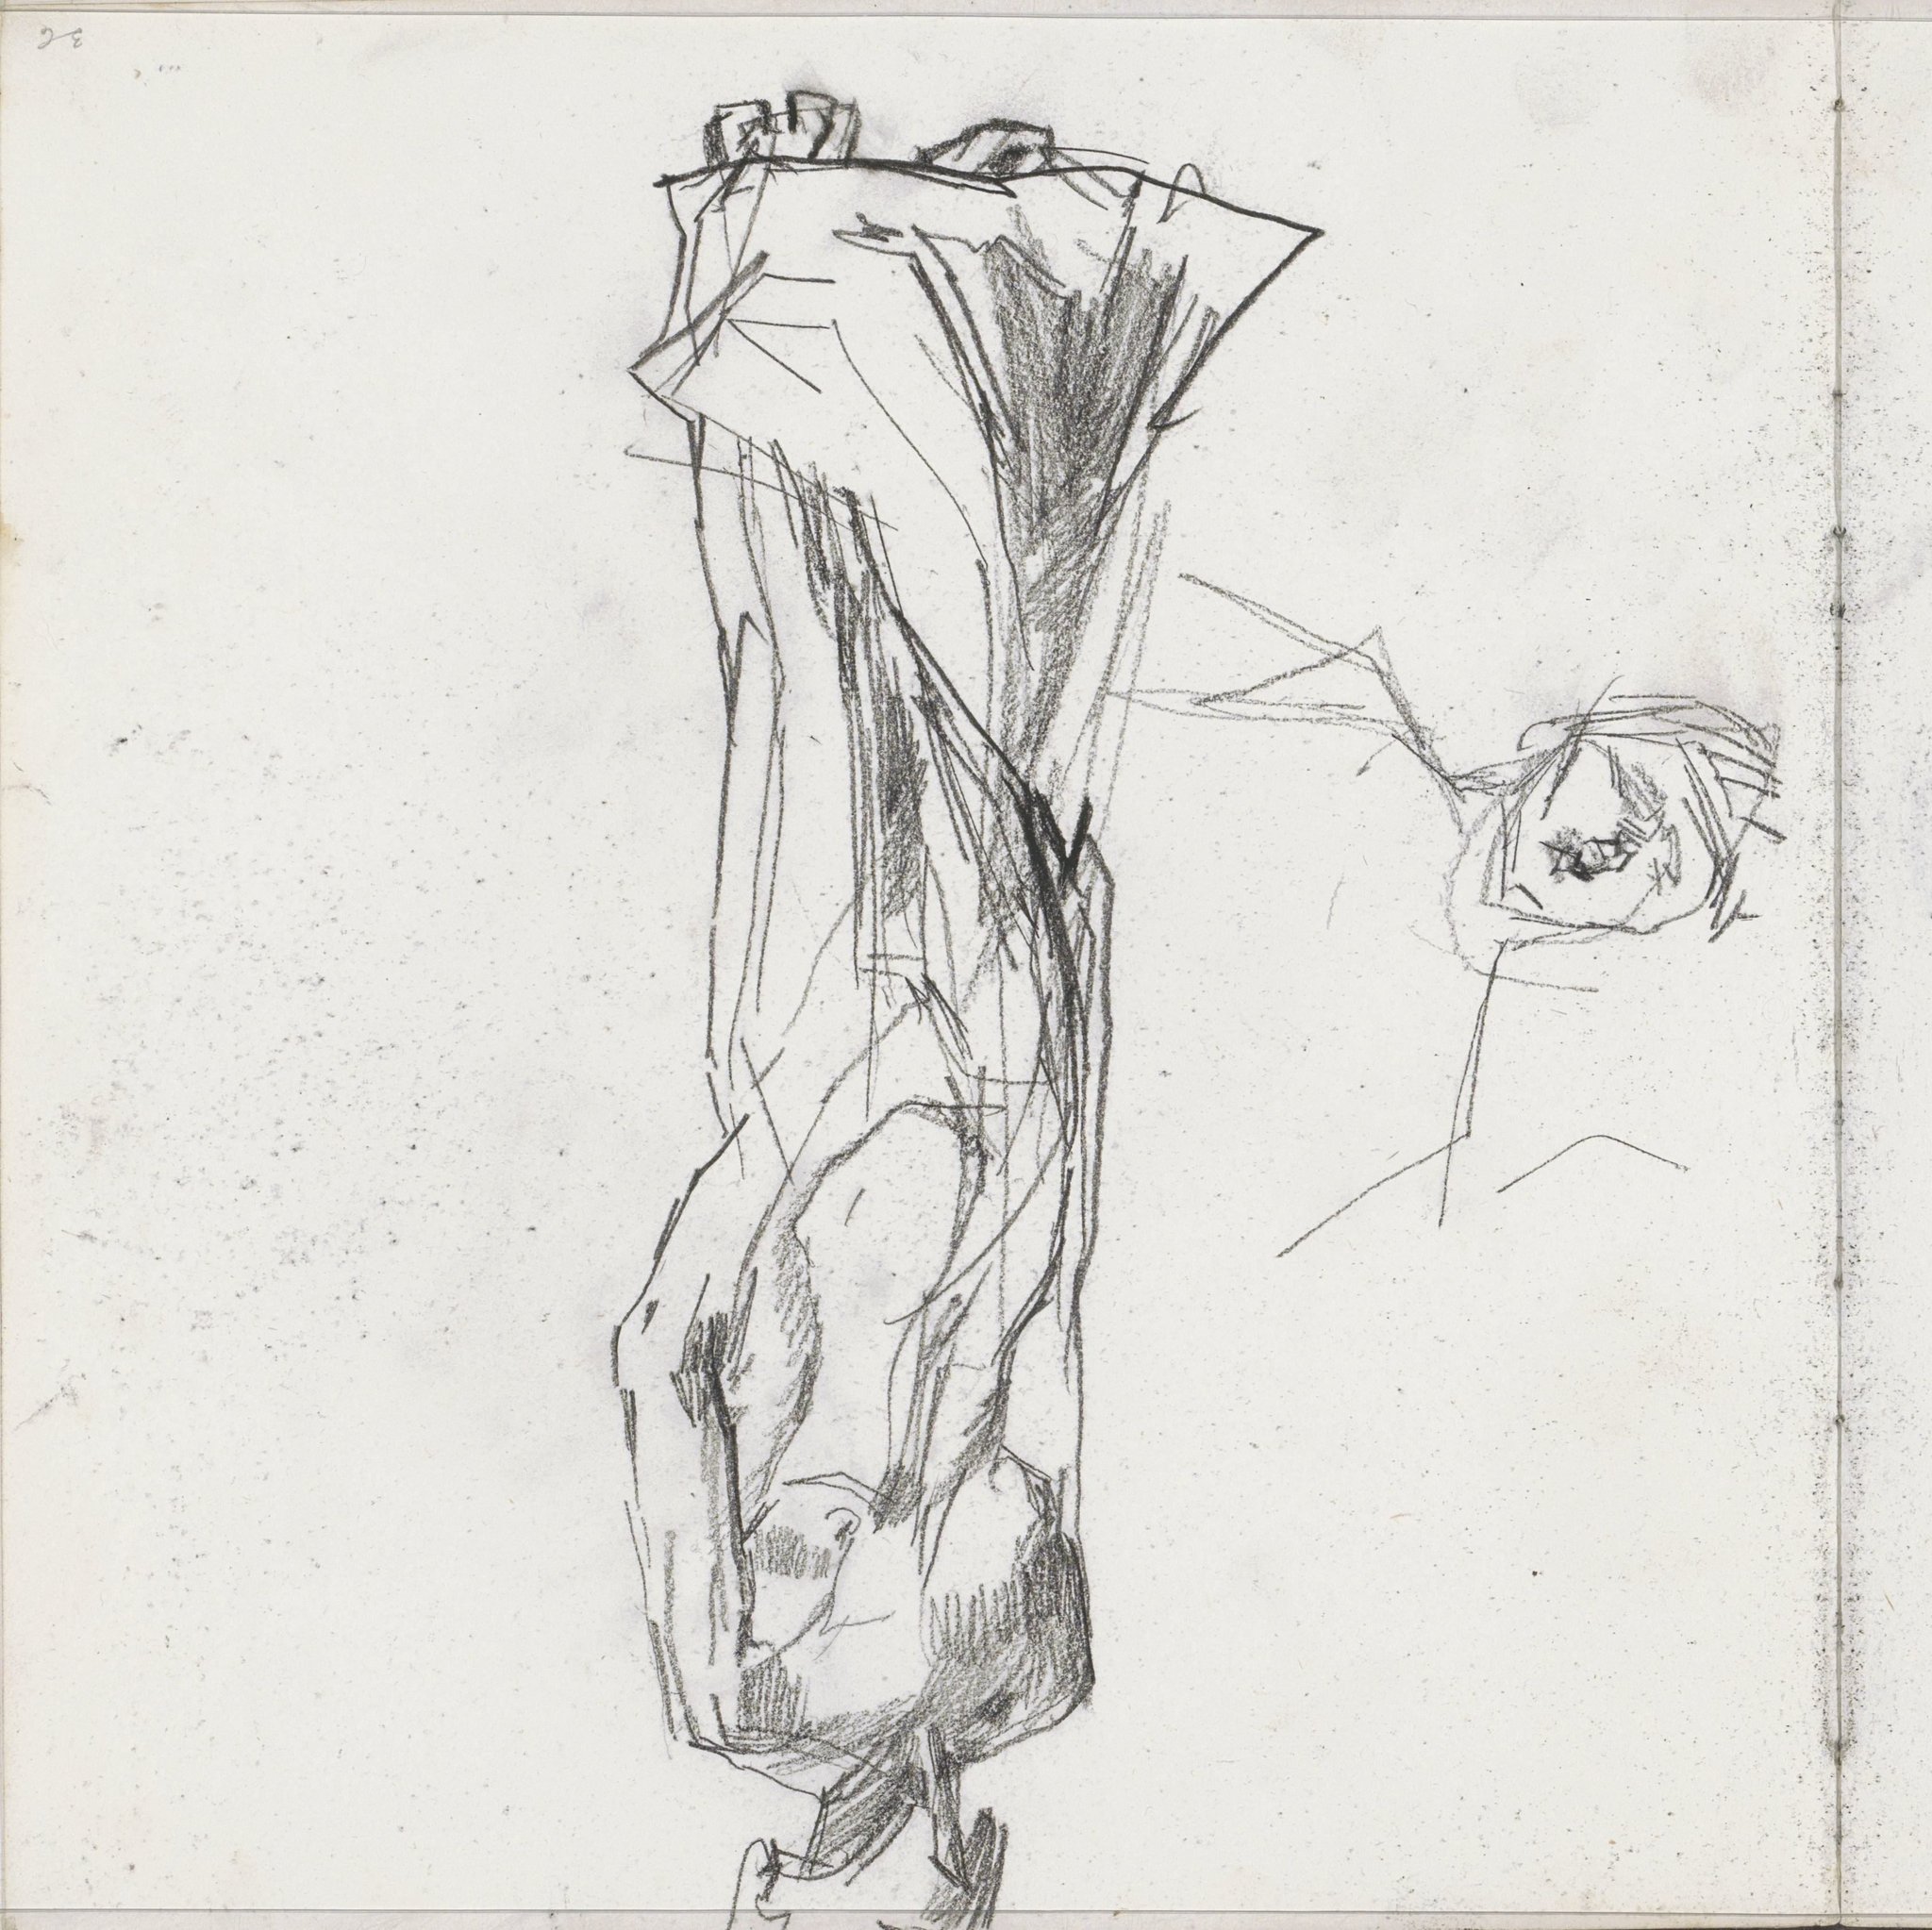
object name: sketchbook leaf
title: Staand vrouwelijk naakt en een hoofd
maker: isaac israels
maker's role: draughtsman, painter, print maker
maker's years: 1865-1934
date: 1875-1934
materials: chalk, paper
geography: the hague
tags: head (human), the (nude) human figure; 'corpo humano' (ripa) - aa - female human figure (+ standing)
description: De vrouw houdt een draperie vast. Blad 21 verso uit schetsboek IX met 28 bladen.